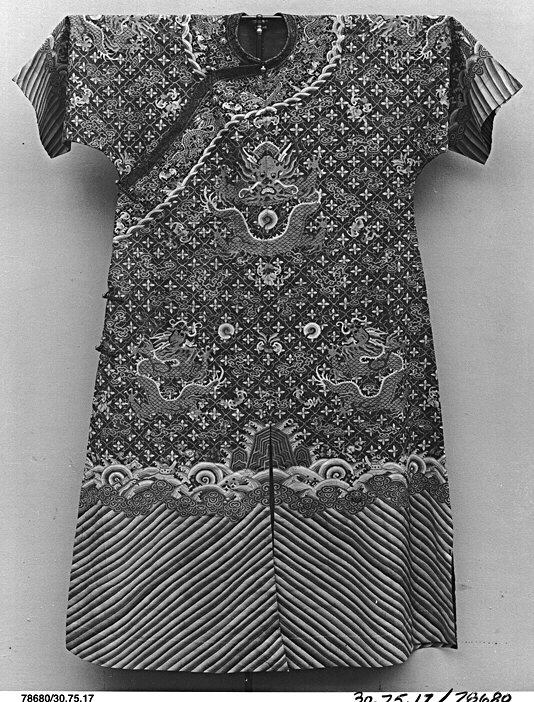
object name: robe, imperial court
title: Imperial Court Robe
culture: chinese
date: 1801-1900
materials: metal thread, silk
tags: dragons